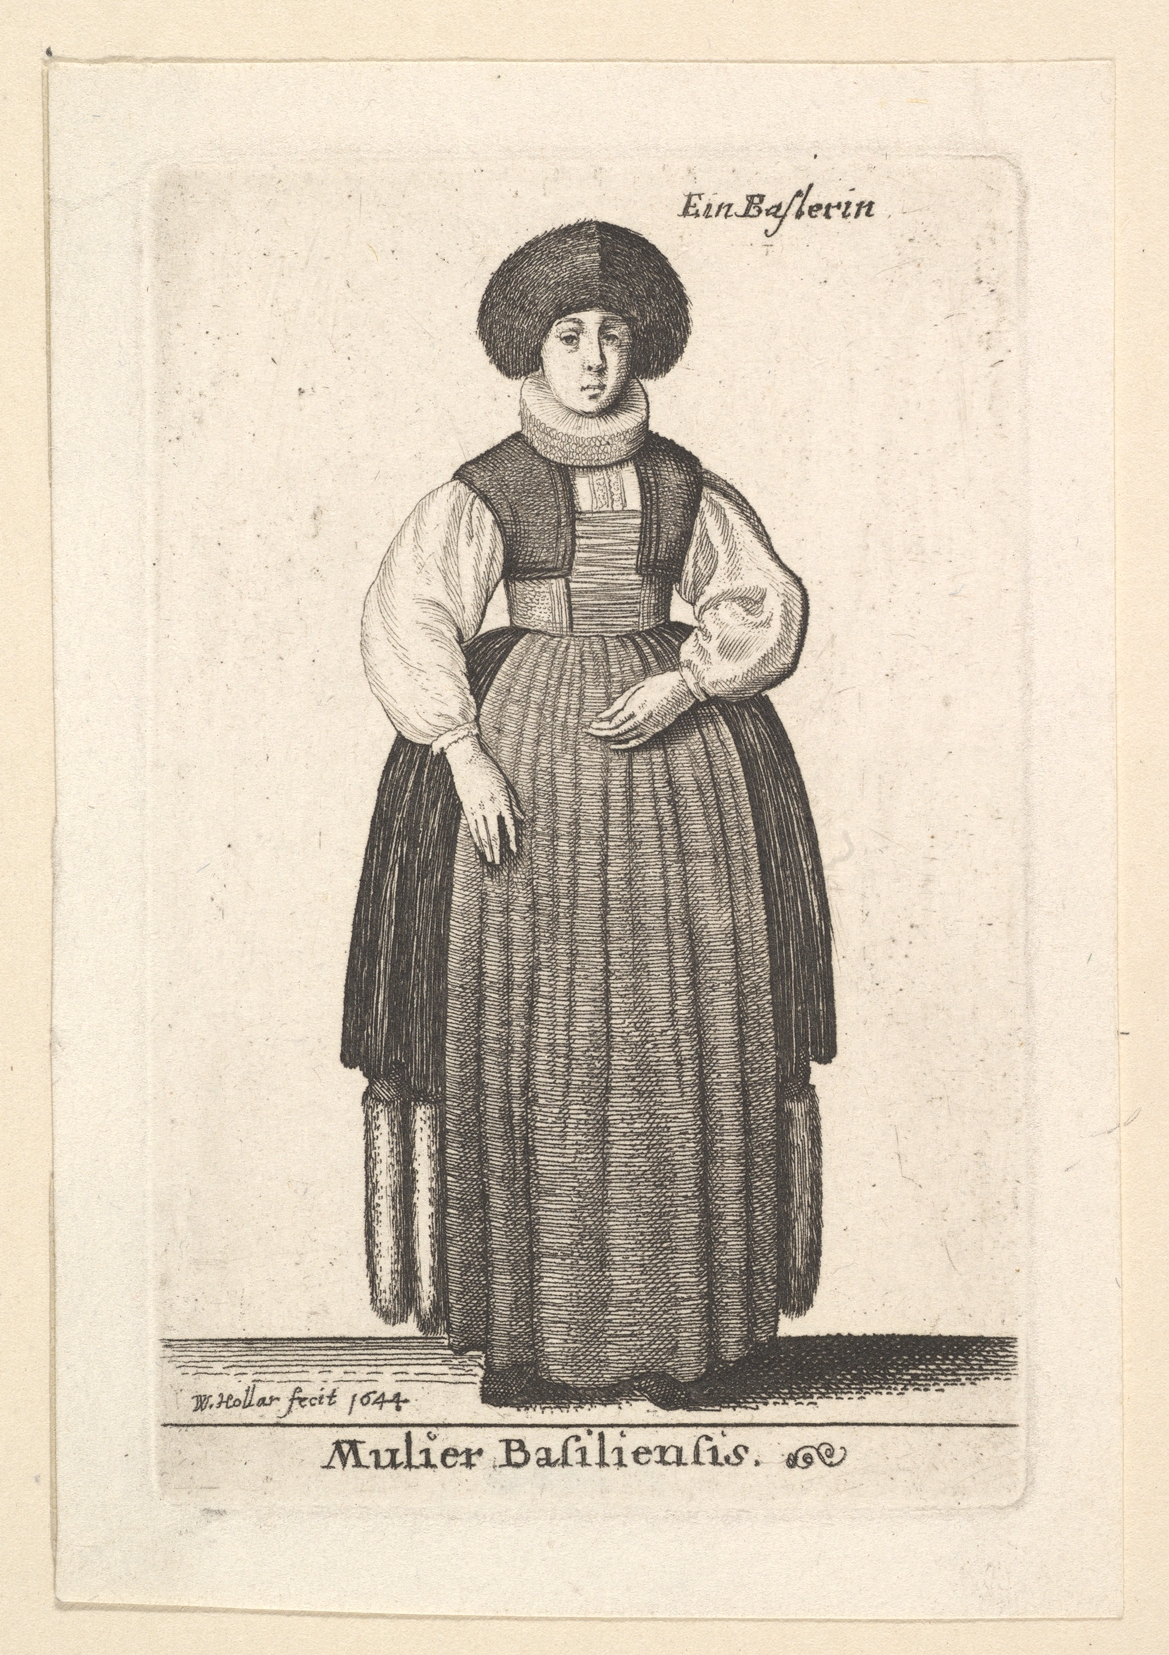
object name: print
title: Mulier Basiliensis (Woman of Basel)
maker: wenceslaus hollar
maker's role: artist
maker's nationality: bohemian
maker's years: 1607-1677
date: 1644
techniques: etching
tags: women